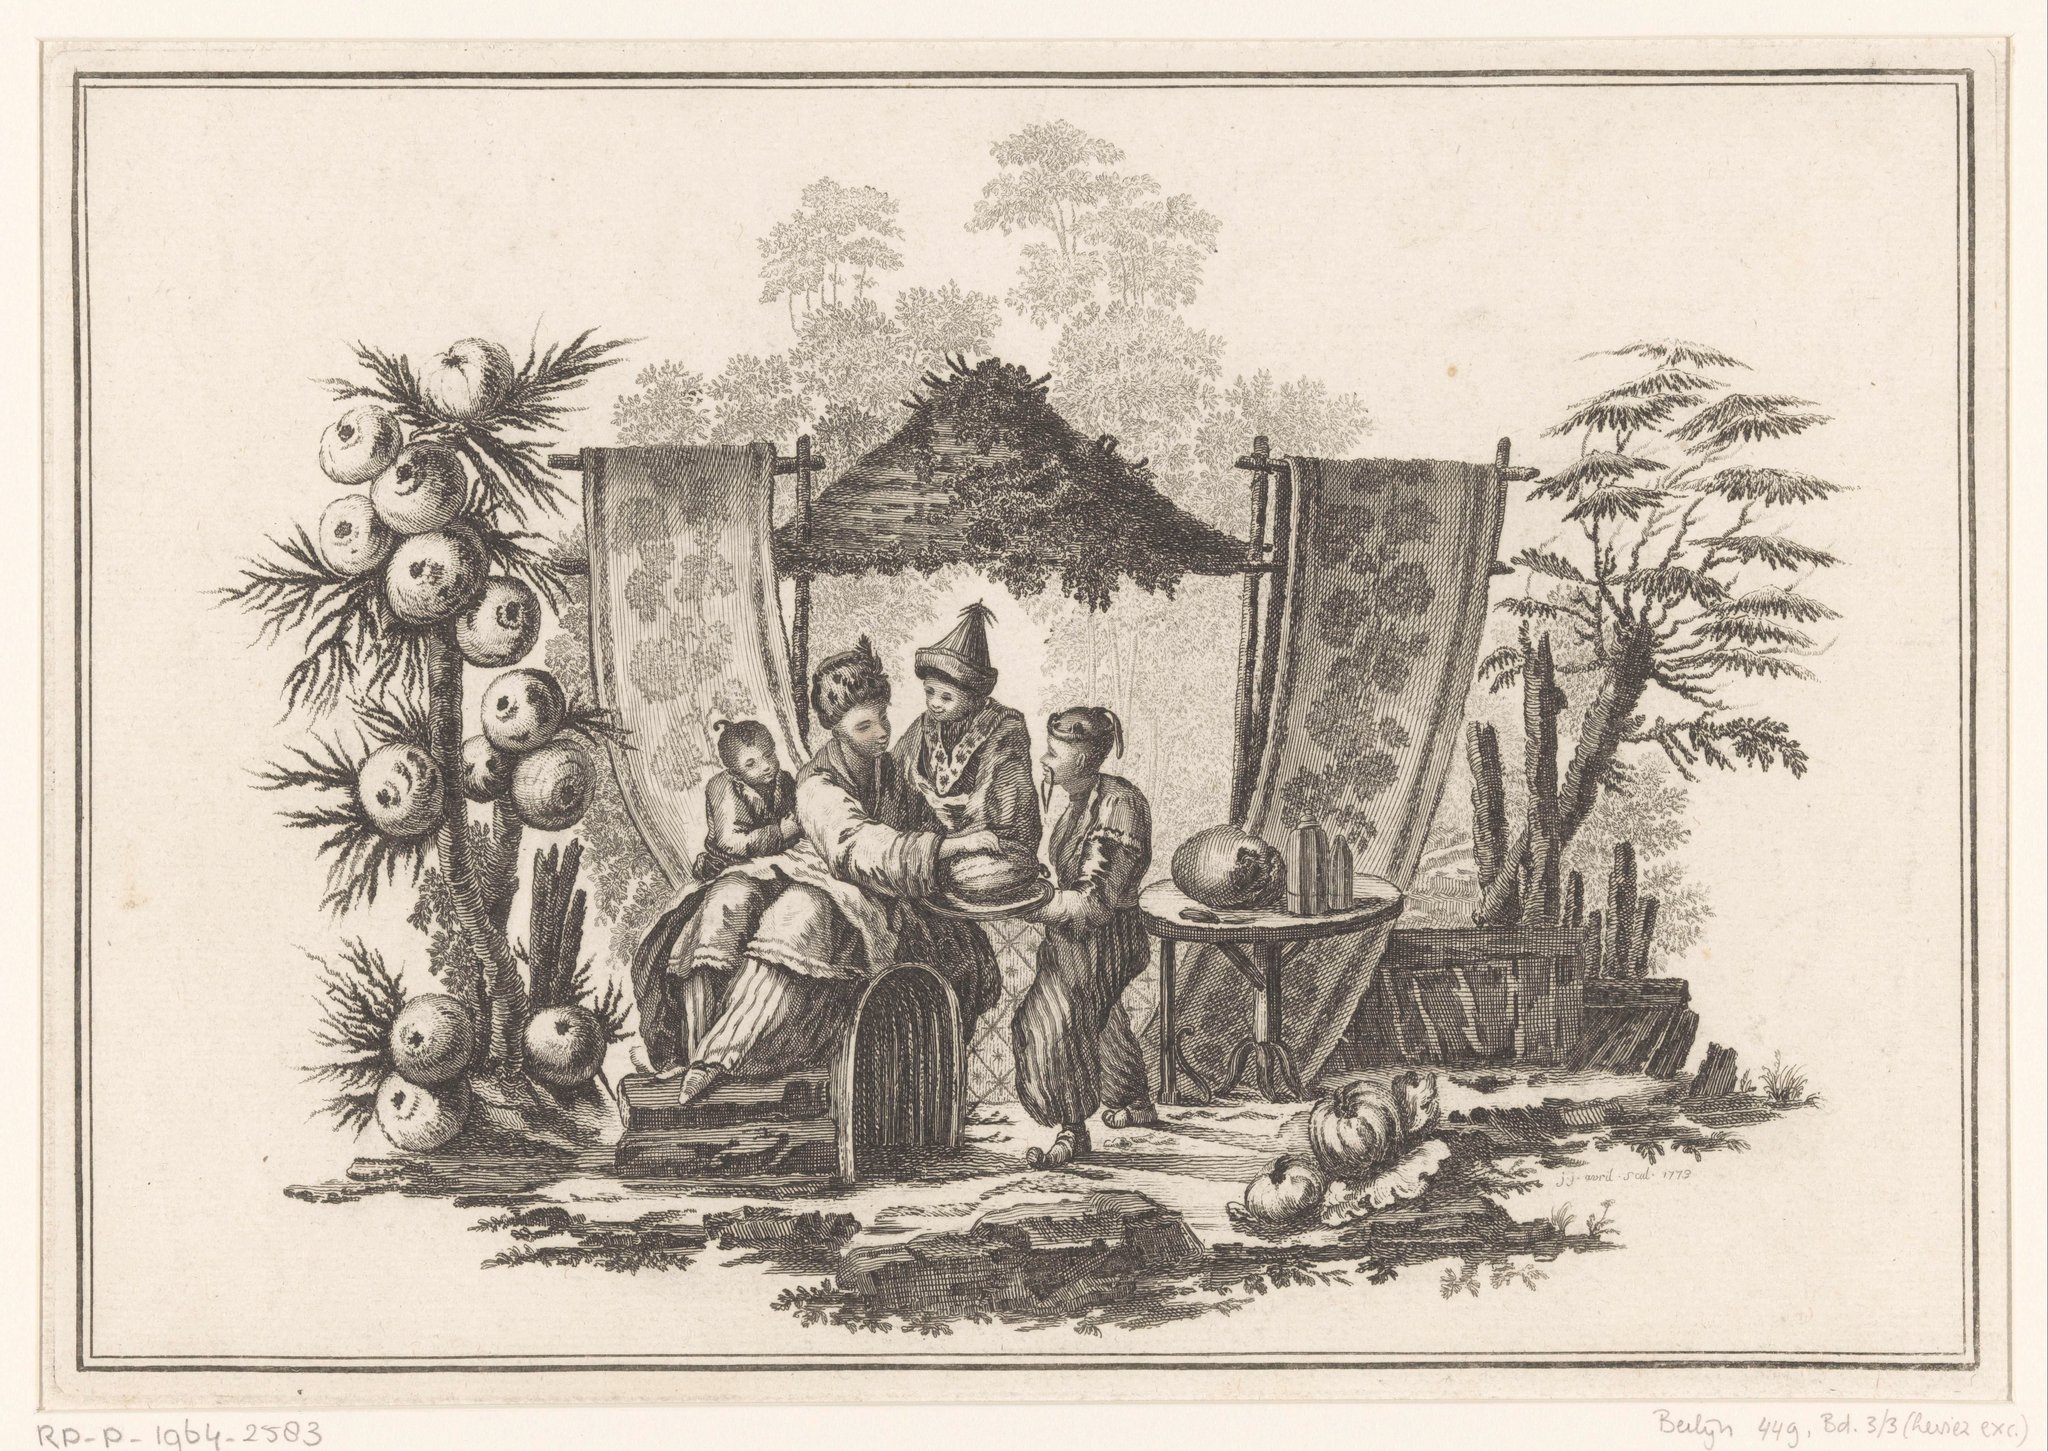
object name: print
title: Nouveau Cahier de Six Feuilles De Différents Sujets Chinois Historiés, Représentant les Cinq Sens de Natures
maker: jean jacques avril (i)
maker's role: print maker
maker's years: 1744-1831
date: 1773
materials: paper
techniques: etching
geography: paris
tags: taste, tasting (one of the five senses)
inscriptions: collector's mark: Lugt 2228, collector's mark: Lugt 2760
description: Personificatie van het zintuig de smaak. In een landschap zitten een man en een kind op een stoel. Achter staat een derde figuur. Een bediende rechts brengt hen een grote vrucht op een schaal.